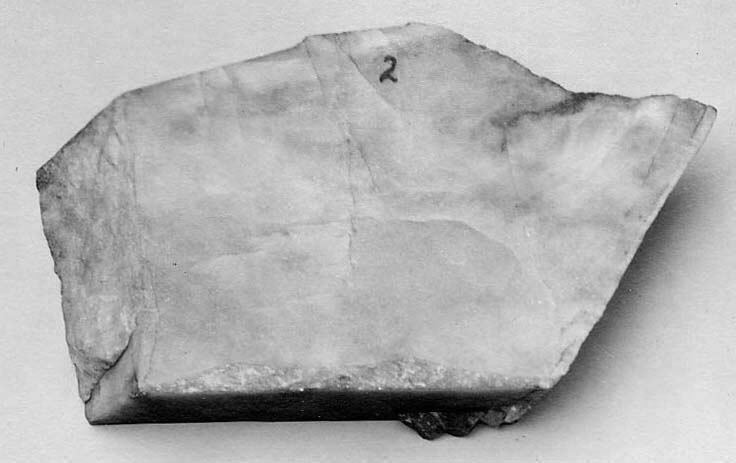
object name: fragment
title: Thick Flat Section of Jadeite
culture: burmese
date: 1902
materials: jade